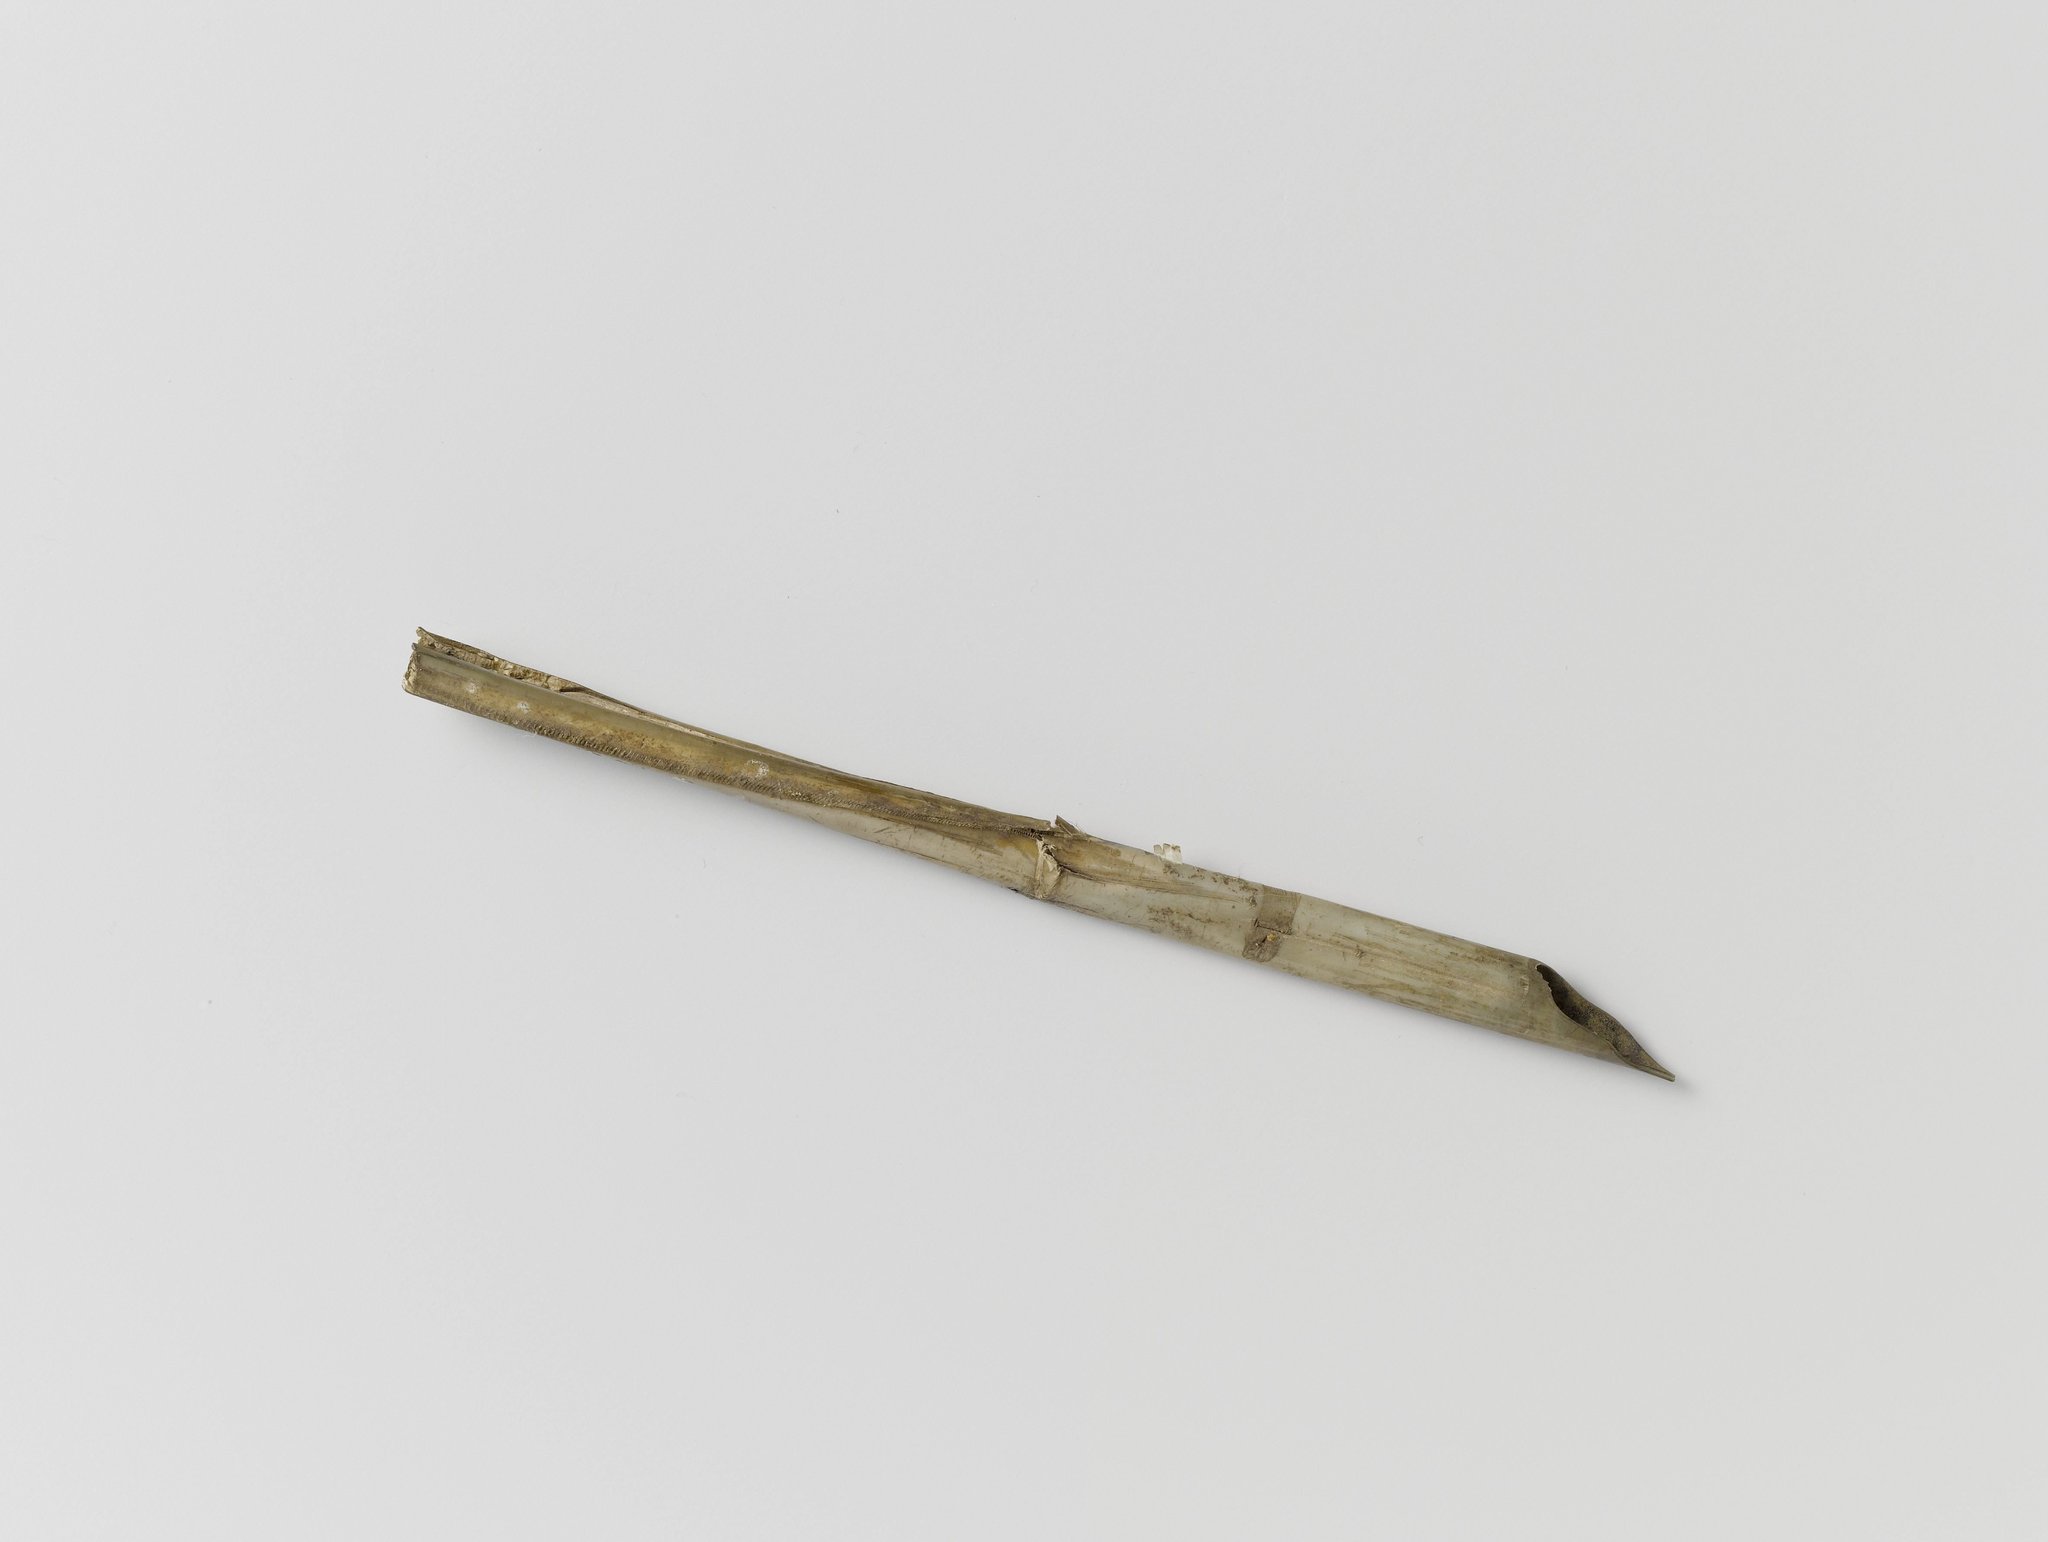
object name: quill pen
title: Ganzenveren schrijfpen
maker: Anonymous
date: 1590-1596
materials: feather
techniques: cutting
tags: willem barendsz., amsterdam, jacob van heemskerck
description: Goose-quill pens